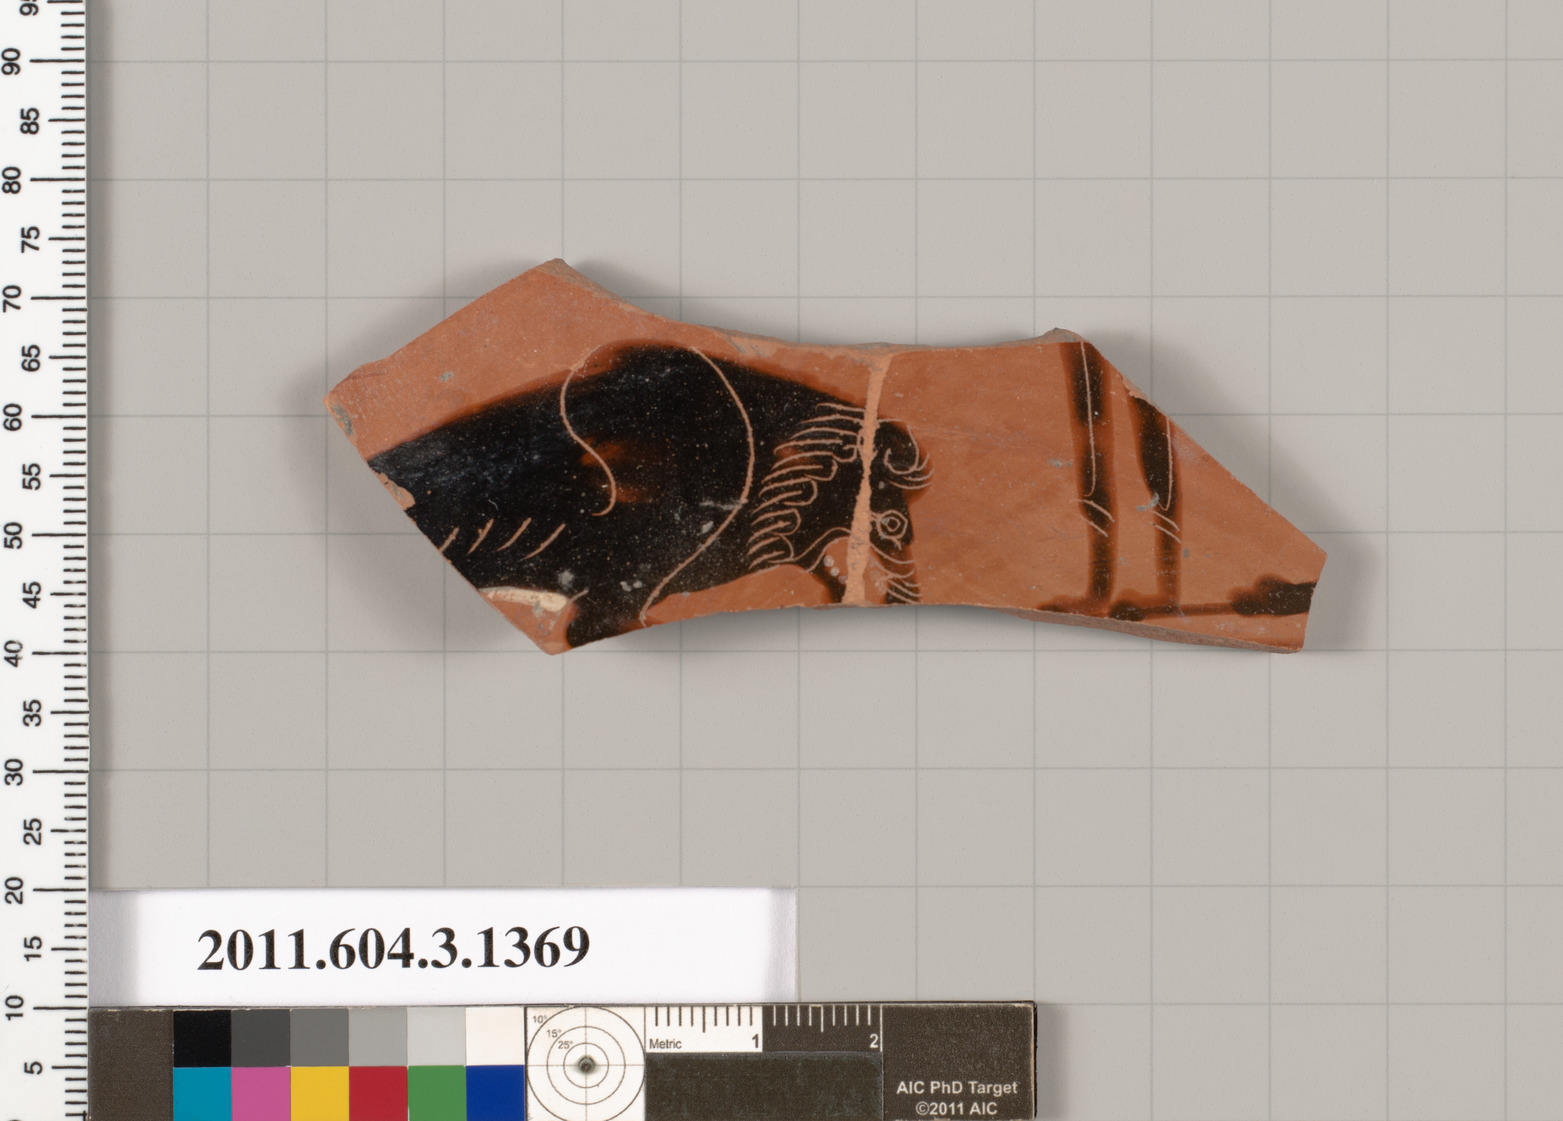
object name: skyphos fragment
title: Terracotta fragment of a skyphos (deep drinking cup)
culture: greek, attic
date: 500-468 BCE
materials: terracotta